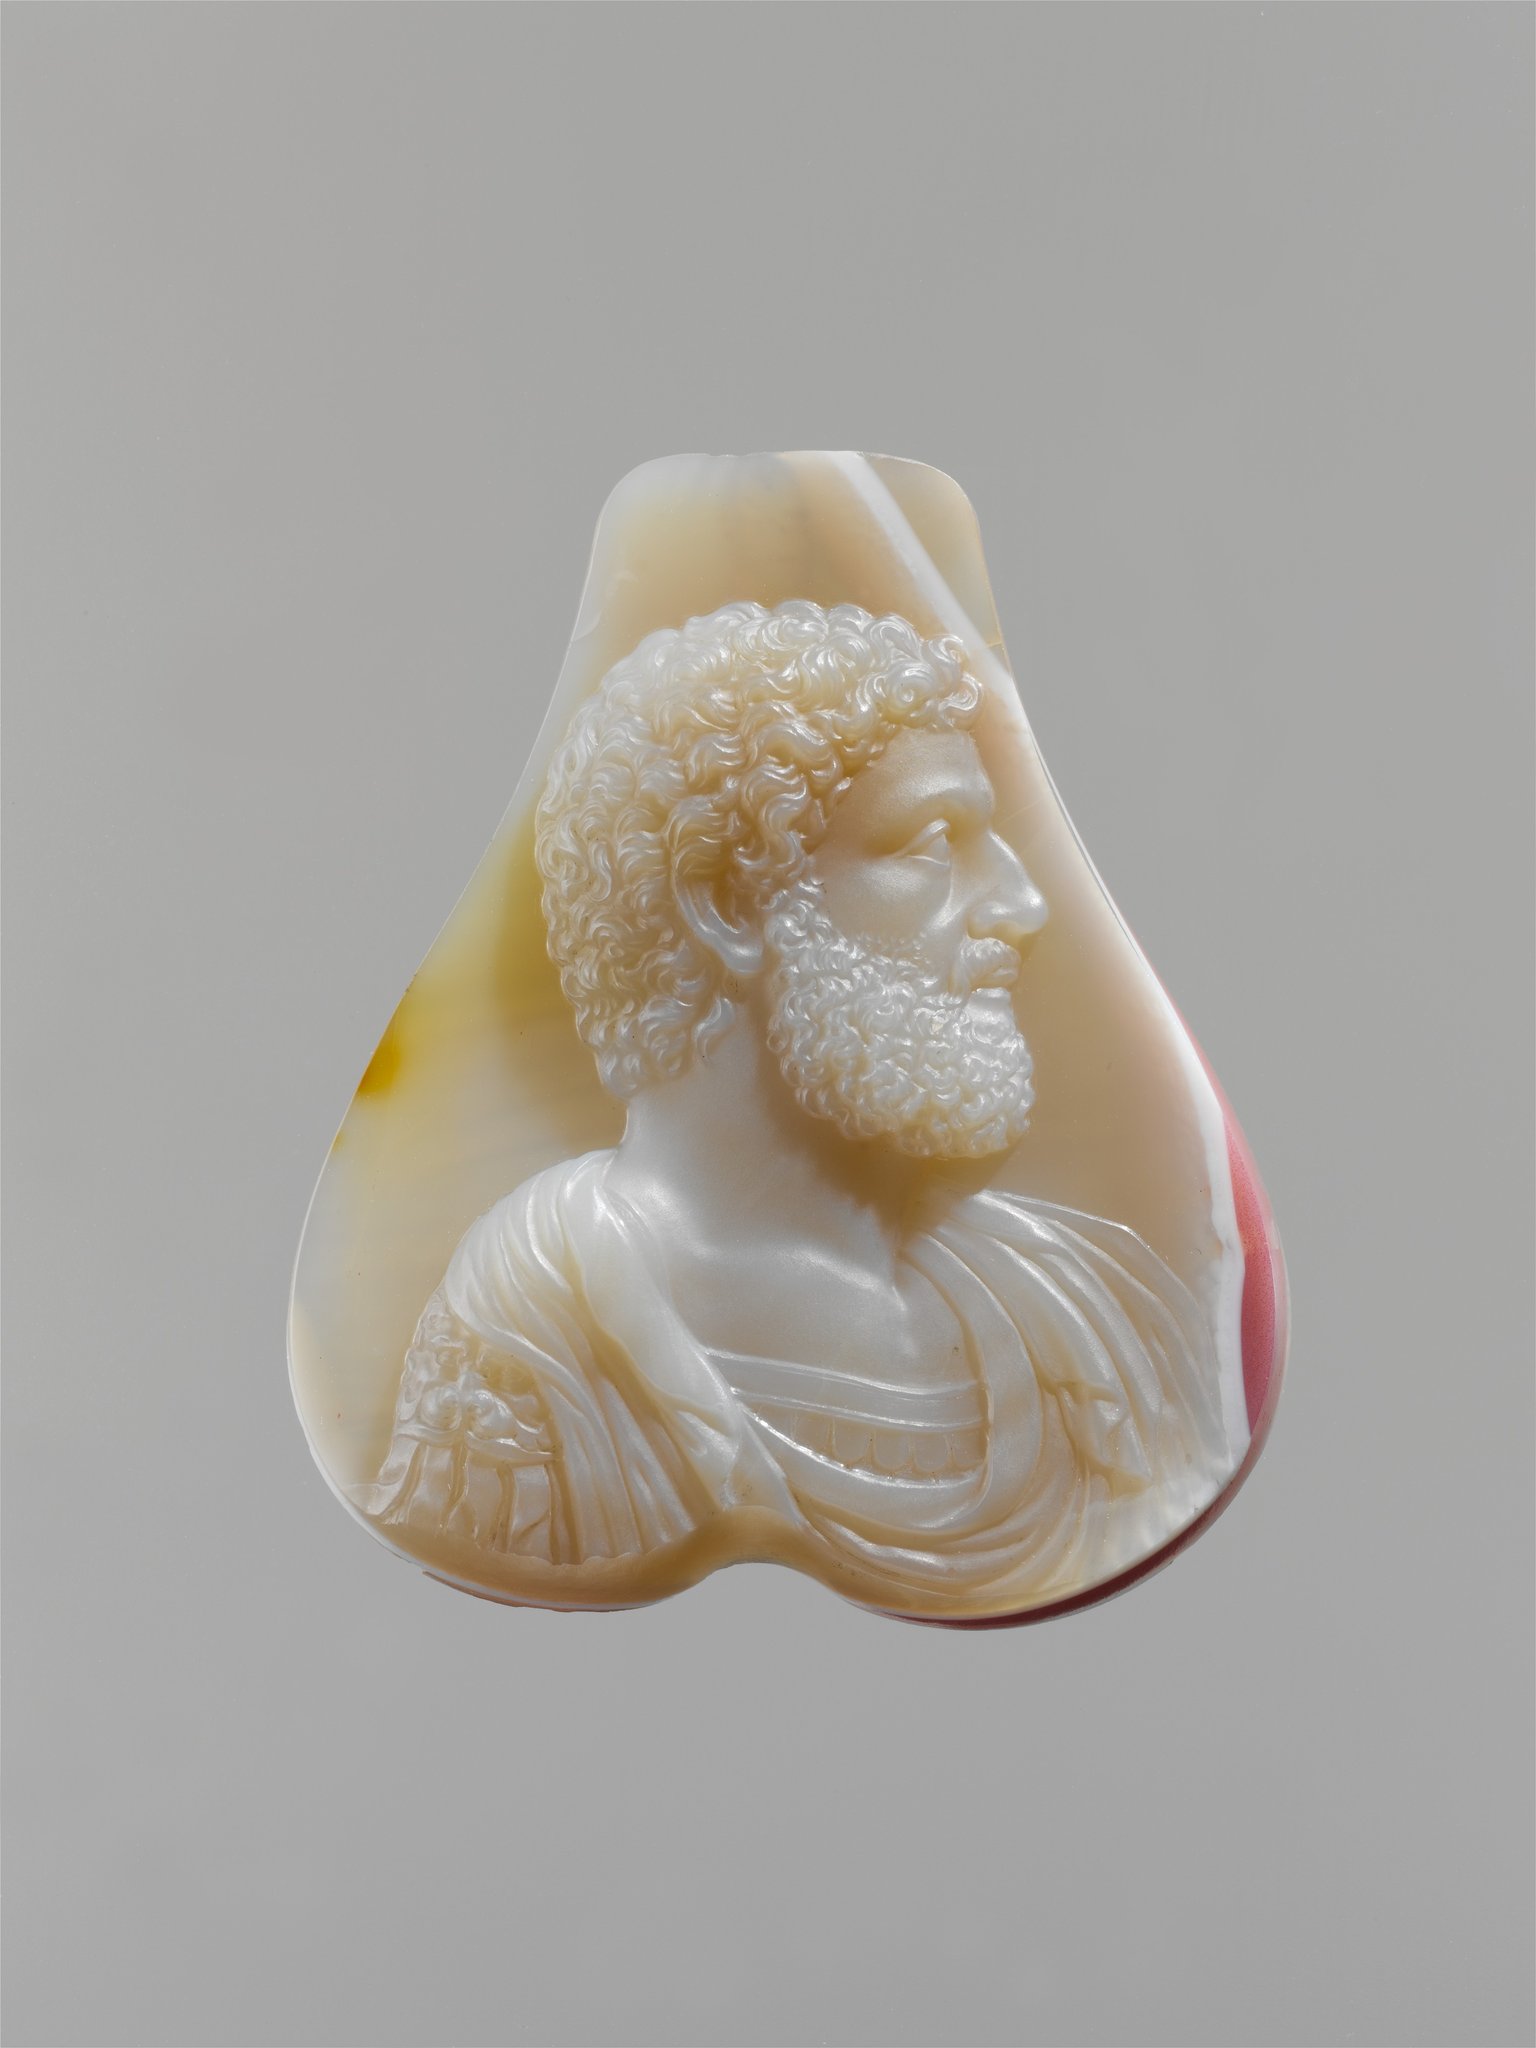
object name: cameo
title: Bust of an unidentified Emperor of the Antonine dynasty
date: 1534-1566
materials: stone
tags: men,profiles